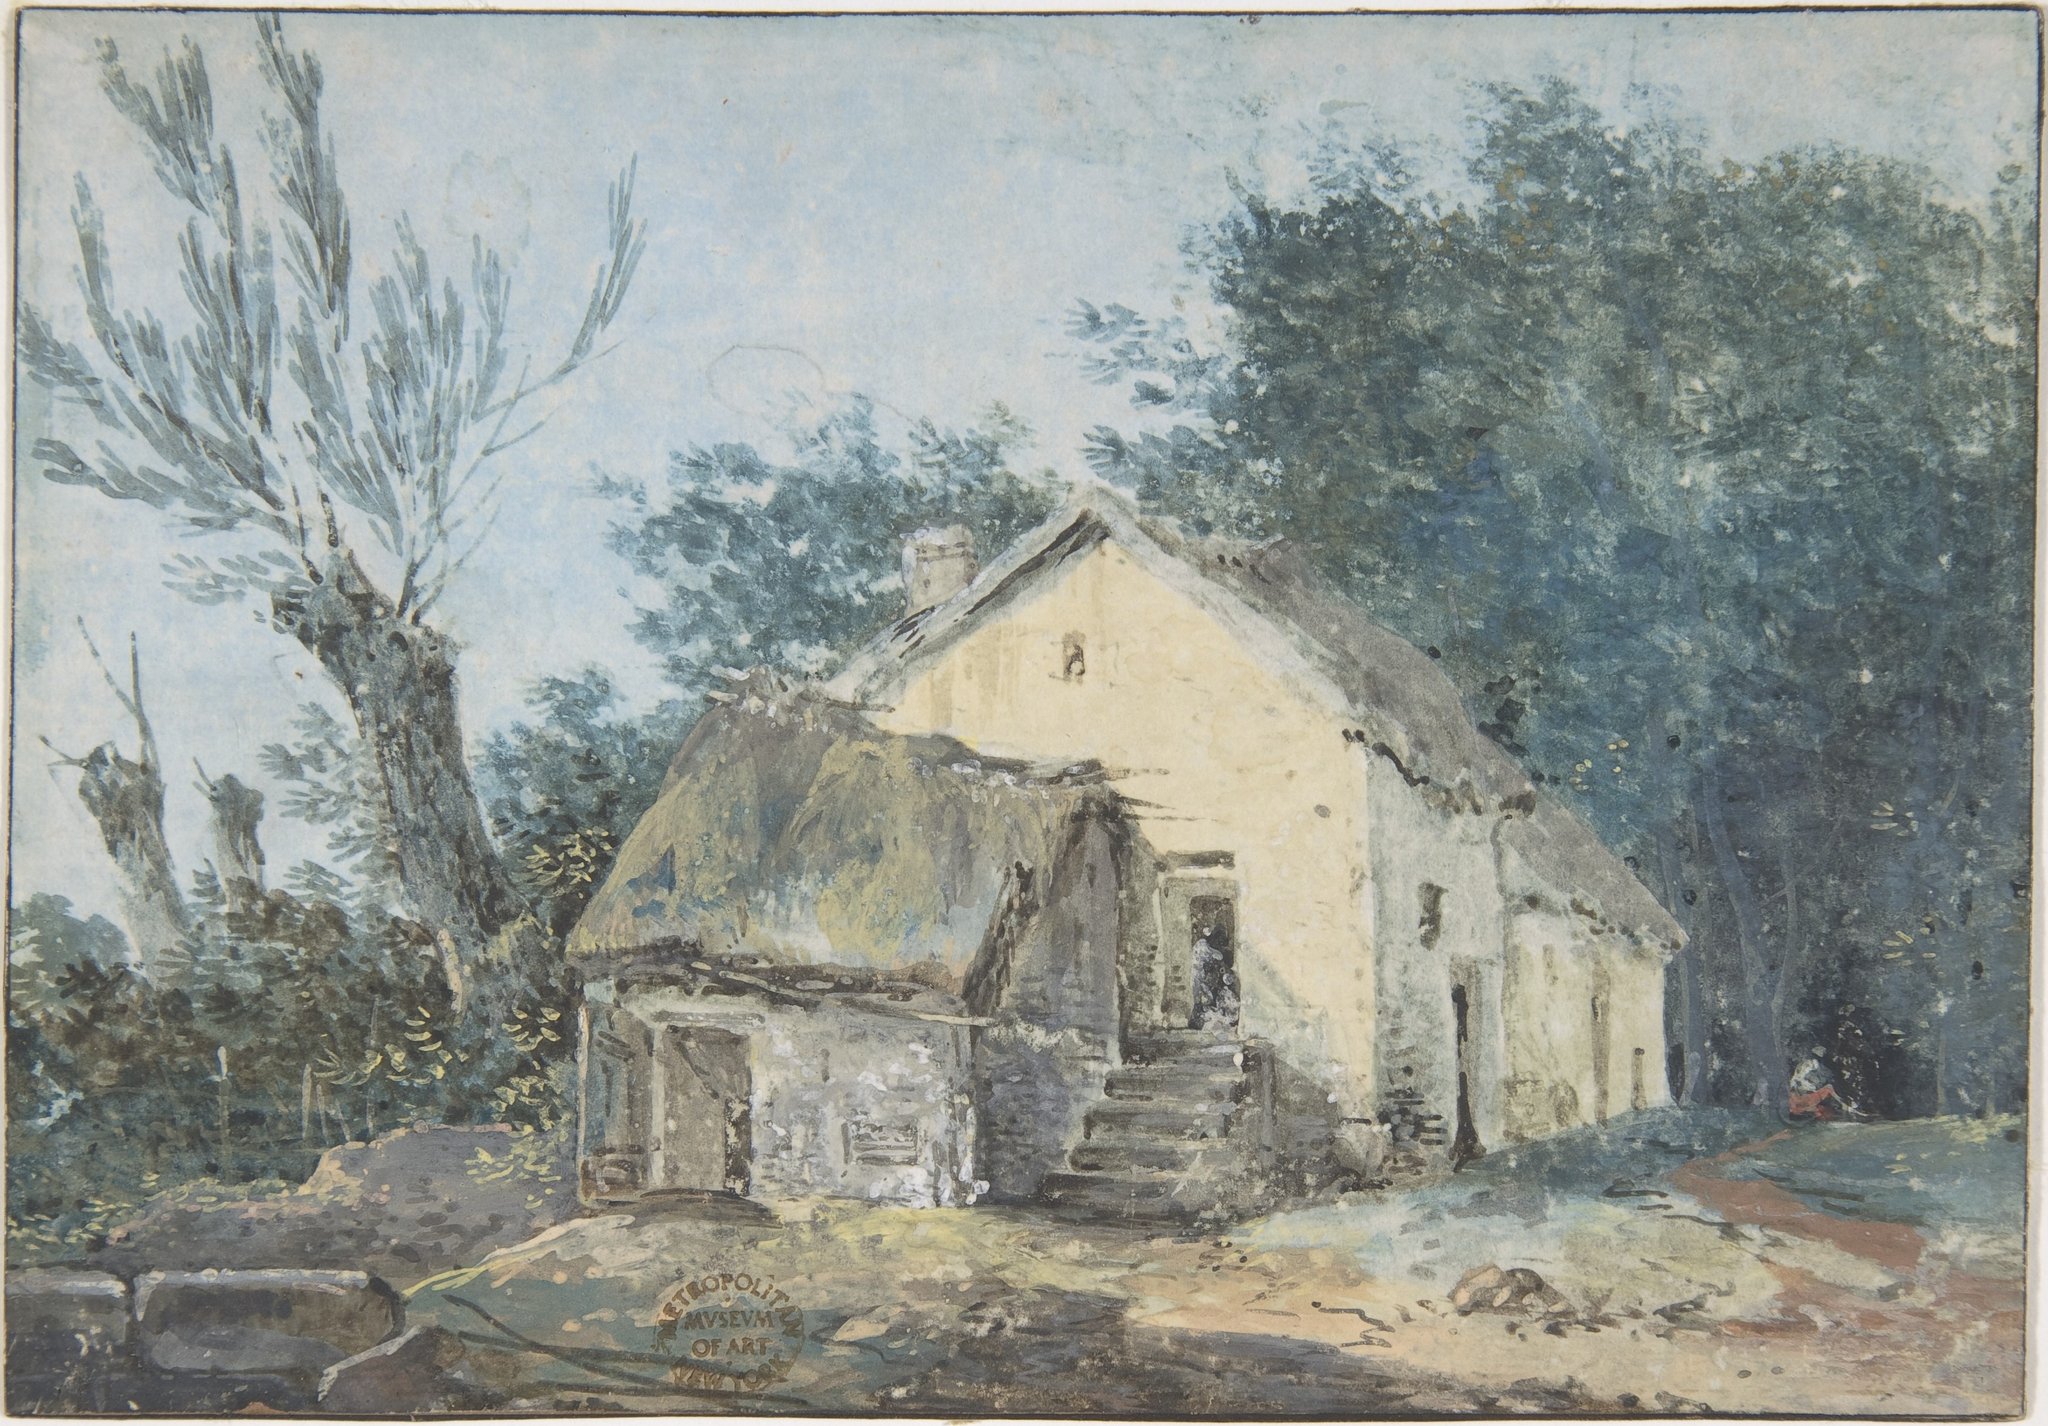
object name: drawing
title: Landscape – Cottage in a Wood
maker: anonymous, french, 18th century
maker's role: artist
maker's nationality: french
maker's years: 1700-1800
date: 1701-1800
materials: gouache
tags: houses,landscapes,trees